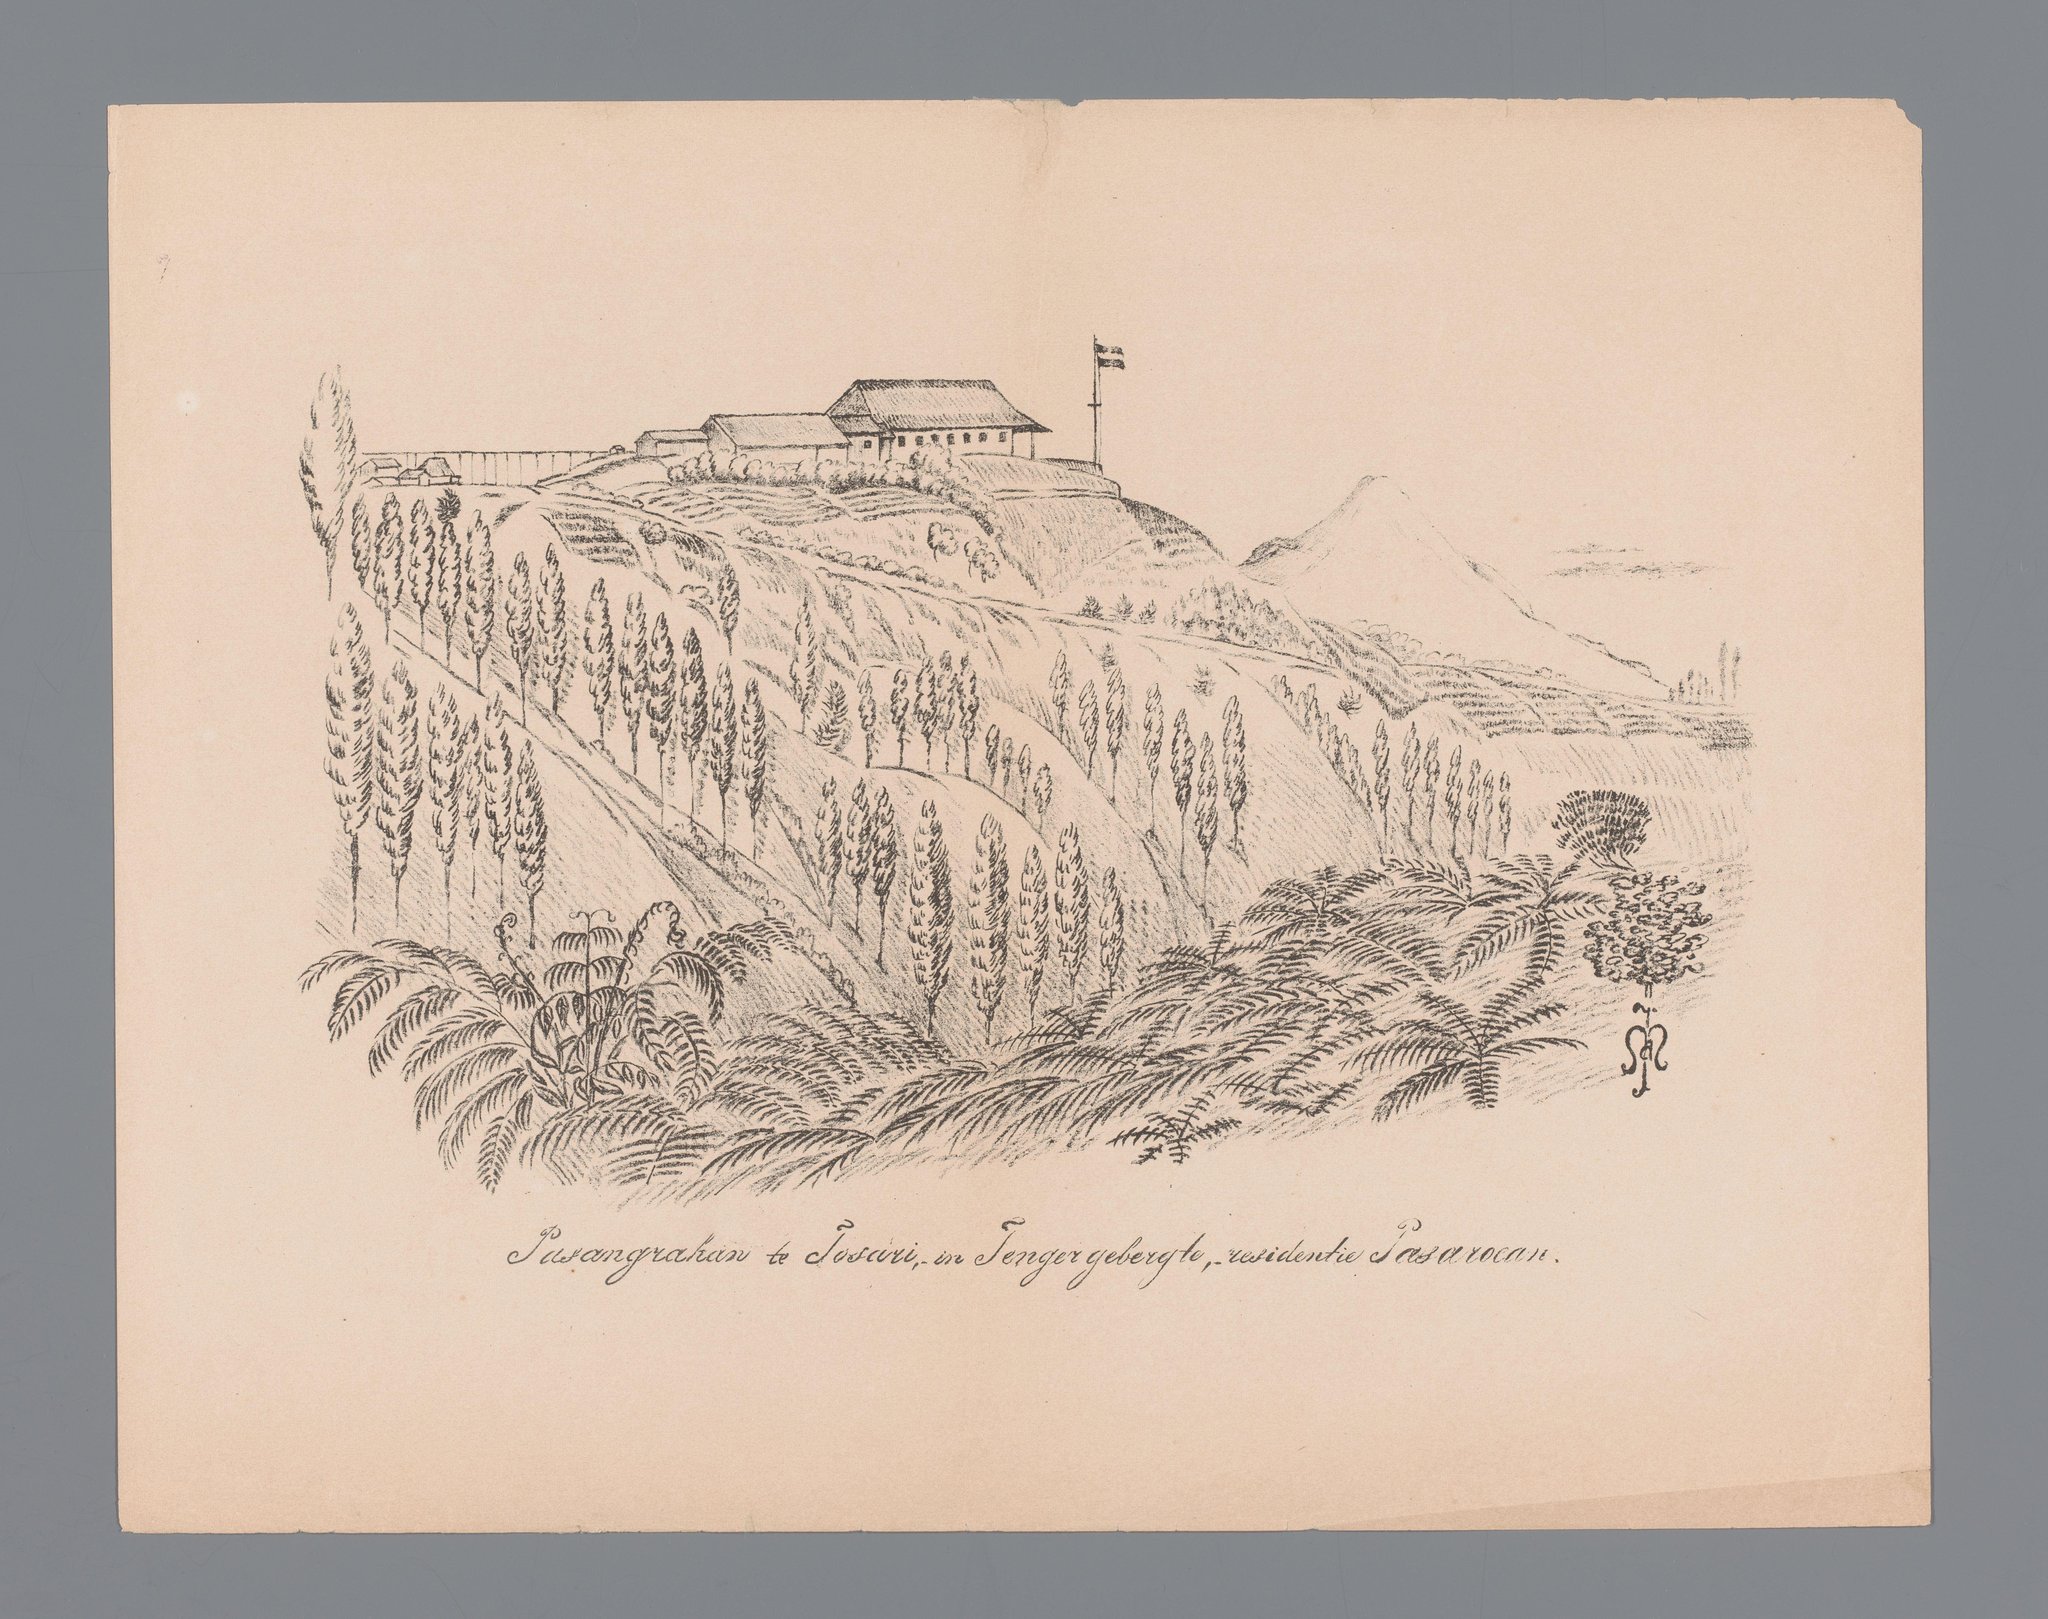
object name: print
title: Bladen uit een Indisch schetsboek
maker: willem mathol de jong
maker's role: print maker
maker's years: 1828-1886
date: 1838-1886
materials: paper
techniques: lithograph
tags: landscapes in tropical and sub-tropical regions, hotel, hostelry, inn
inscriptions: collector's mark: Lugt 2228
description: Het hotel ligt op een heuvel en kijkt uit over de vallei. Maakt deel uit van een omslag met twaalf prenten.